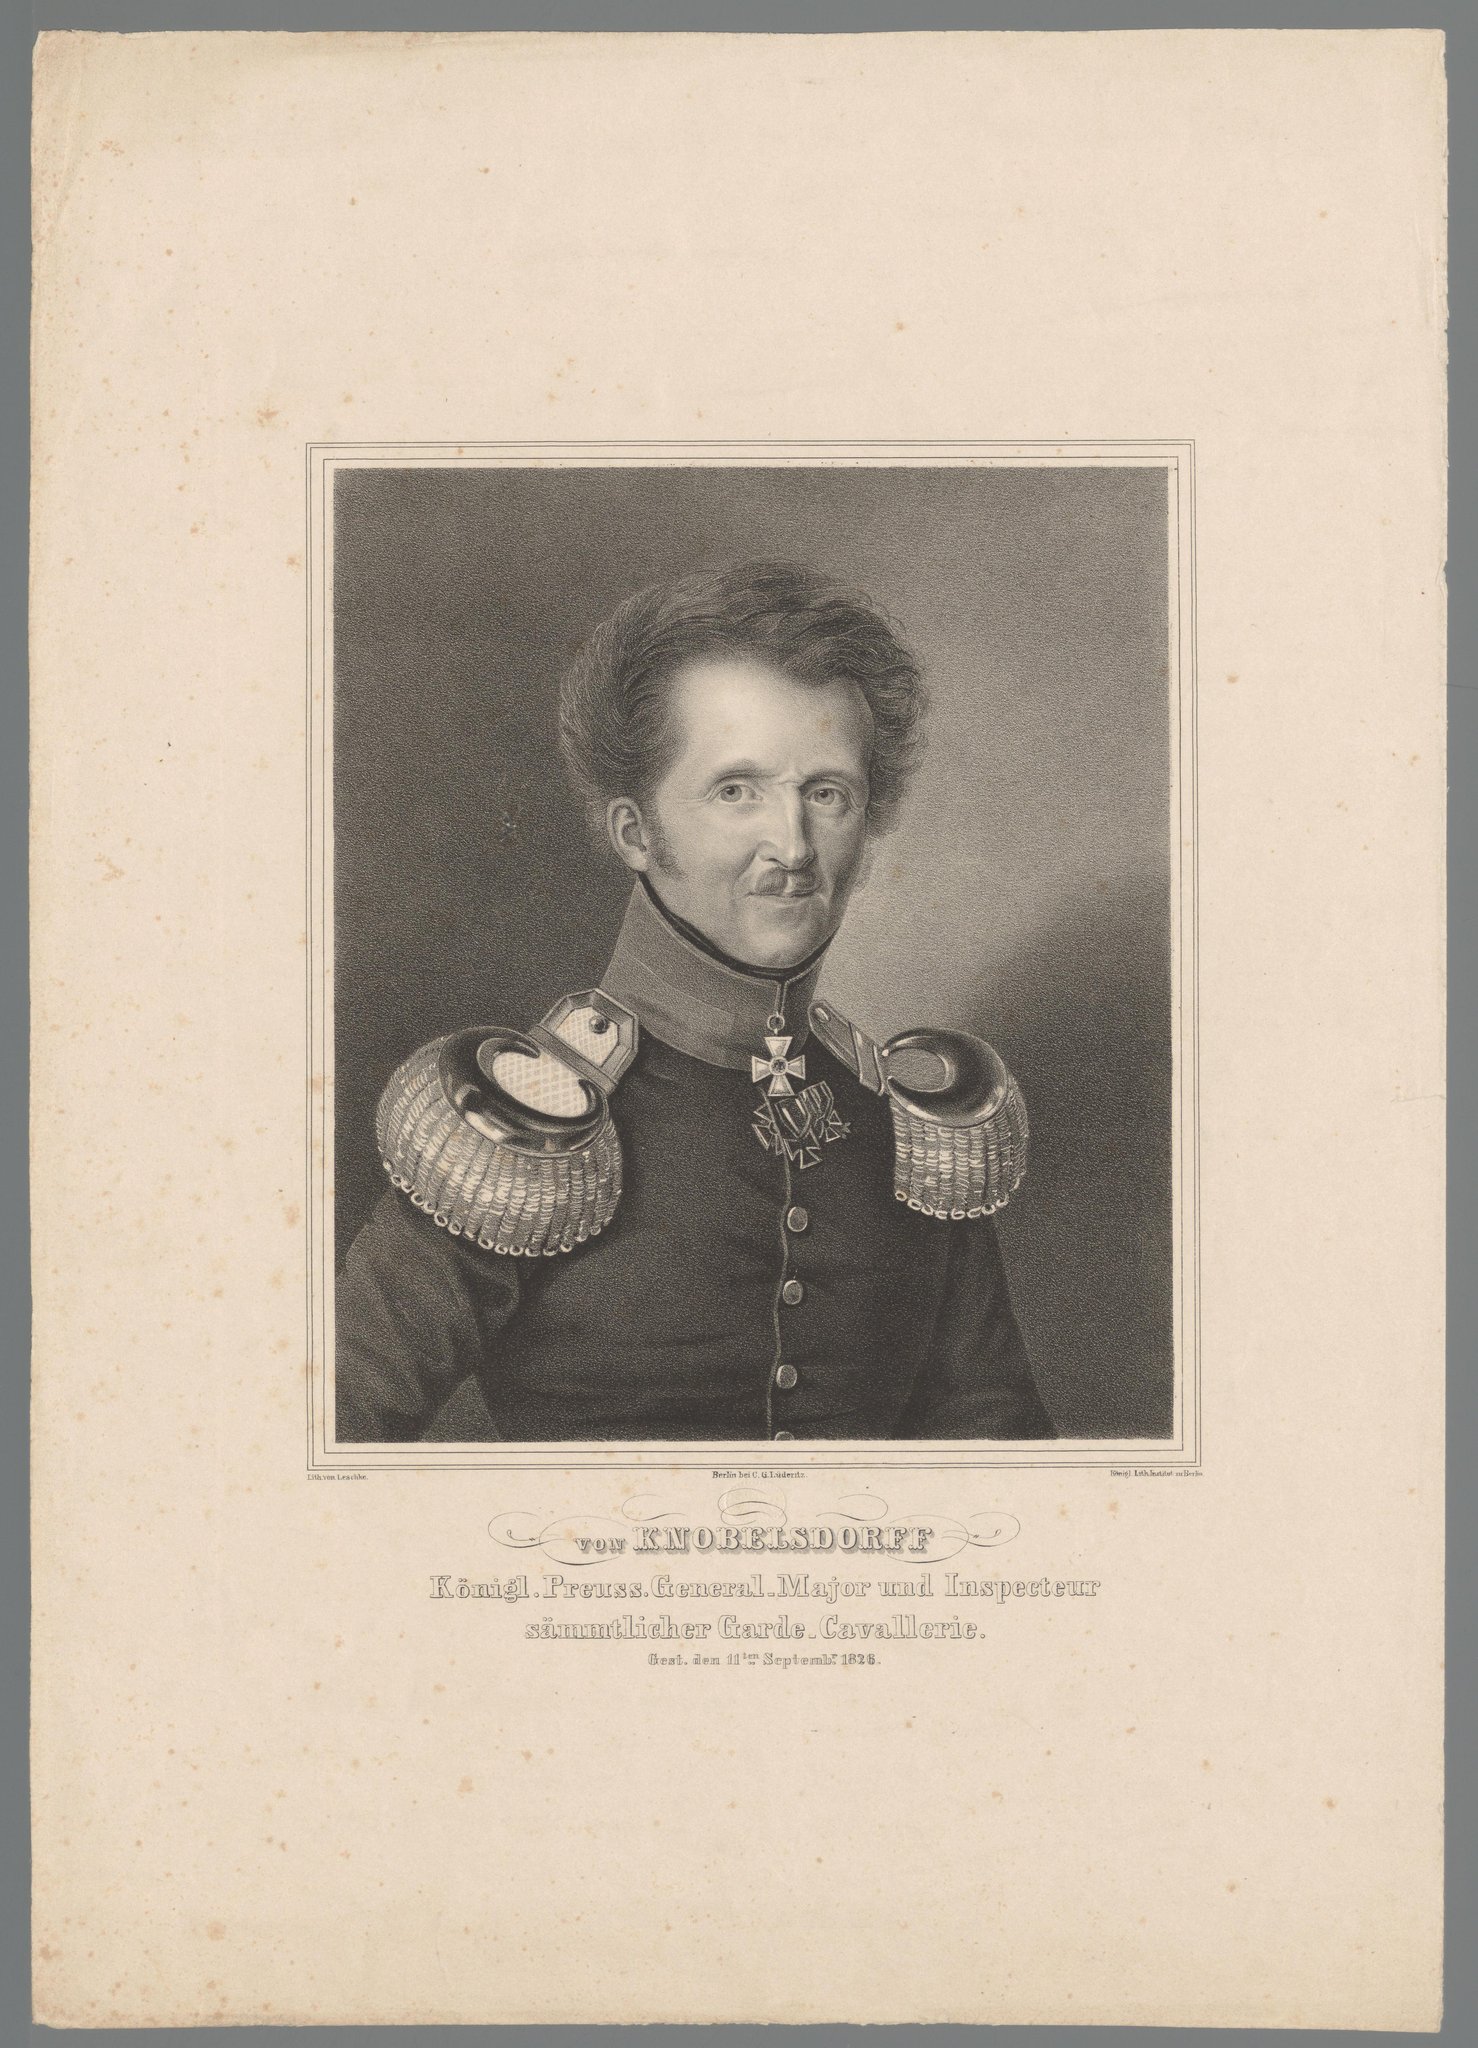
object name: print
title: von Knobelsdorff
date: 1820-1860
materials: paper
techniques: lithograph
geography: berlin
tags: commander-in-chief, general, marshal, historical persons not known by name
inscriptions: collector's mark: Lugt 2228, check stamp: Lugt 4519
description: Portret van een verder onbekende militair met de naam Von Knobelsdorff.